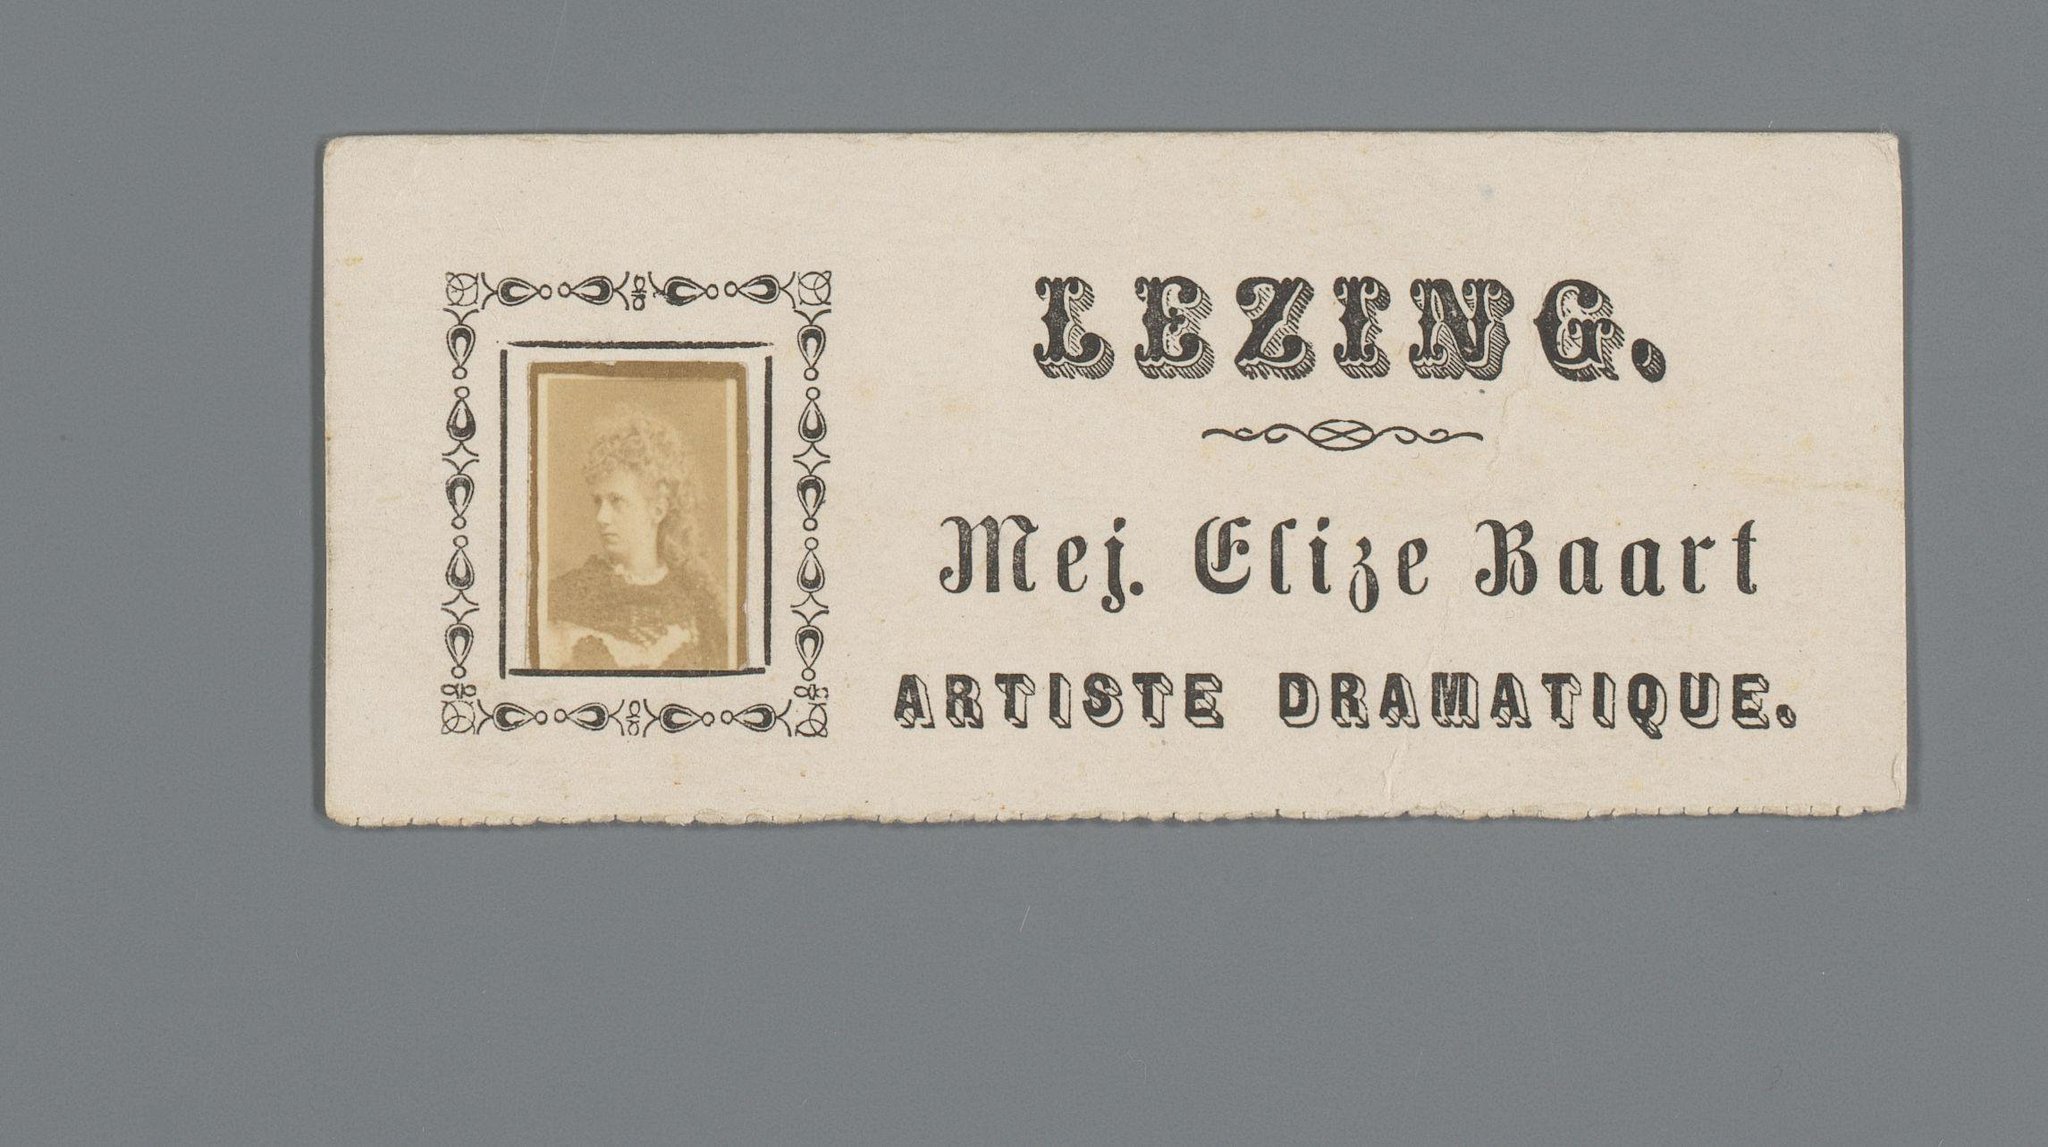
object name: photograph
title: Aankondiging van een lezing over of van Elize Baart met opgeplakt miniatuurportret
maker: Anonymous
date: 1870-1910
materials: cardboard, paper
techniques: albumen print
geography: netherlands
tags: middelburg, adult woman, netherlands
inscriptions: inscription: ‘LEZING./ Mej. Elize Baart/ ARTISTE DRAMATIQUE.’